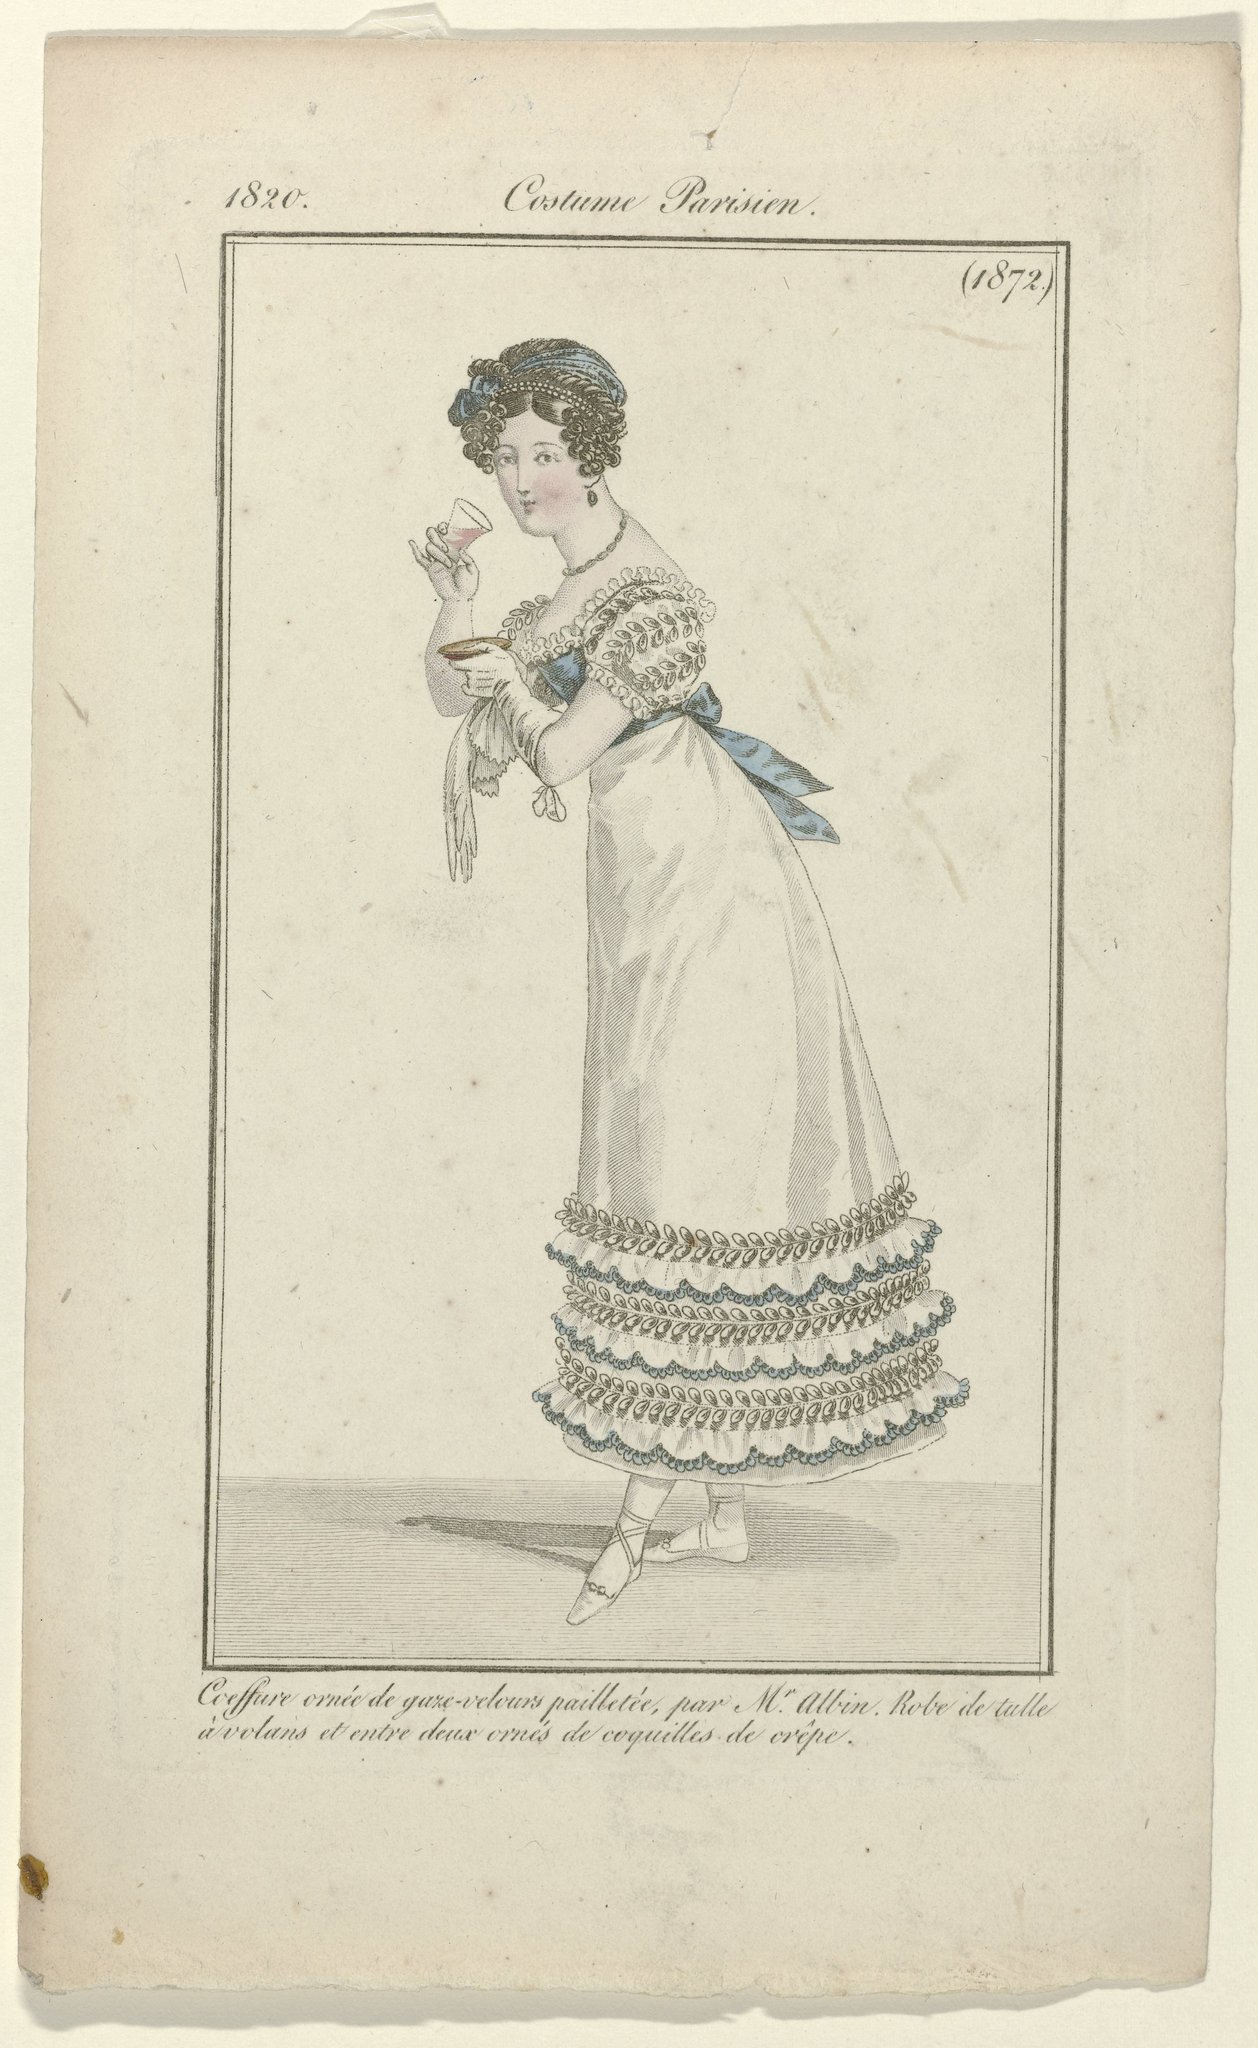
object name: fashion print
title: Journal des Dames et des Modes, Costume Parisien, 15 janvier 1820, (1872): Coeffure ornée de gaze-velours (...)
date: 1820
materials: paper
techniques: engraving, hand coloring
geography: paris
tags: ear-rings (+ women's clothes), diadem, tiara (+ women's clothes), gloves, mittens (long gloves) (+ women's clothes), ornamental parts of clothing (+ women's clothes), styles of hairdress - aa - ~ women, fashion plates, shoes, sandals (+ women's clothes), dress, gown (+ women's clothes), necklace (+ women's clothes), cup and saucer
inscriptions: caption: ‘Coeffure ornée de gaze-velours pailletée, par Mr. Albin. Robe de tulle à volans et entre deux ornés de coquilles de crêpe.’, title: ‘Costume Parisien.’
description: Staande vrouw gekleed in een japon van tule met gerimpelde stroken stof, ertussen versierd met 'coquilles' van crêpe. 'Coeffure' versierd met 'gaze-velours' met pailletten, door Mr Albin. Accessoires: oorbel in het linkeroor, collier, lange handschoenen, platte schoenen met gekruiste banden en strikken. Kop en schotel in de handen. De prent maakt deel uit van het modetijdschrift Journal des Dames et des Modes, uitgegeven door Pierre de la Mésangère, Parijs, 1797-1839.